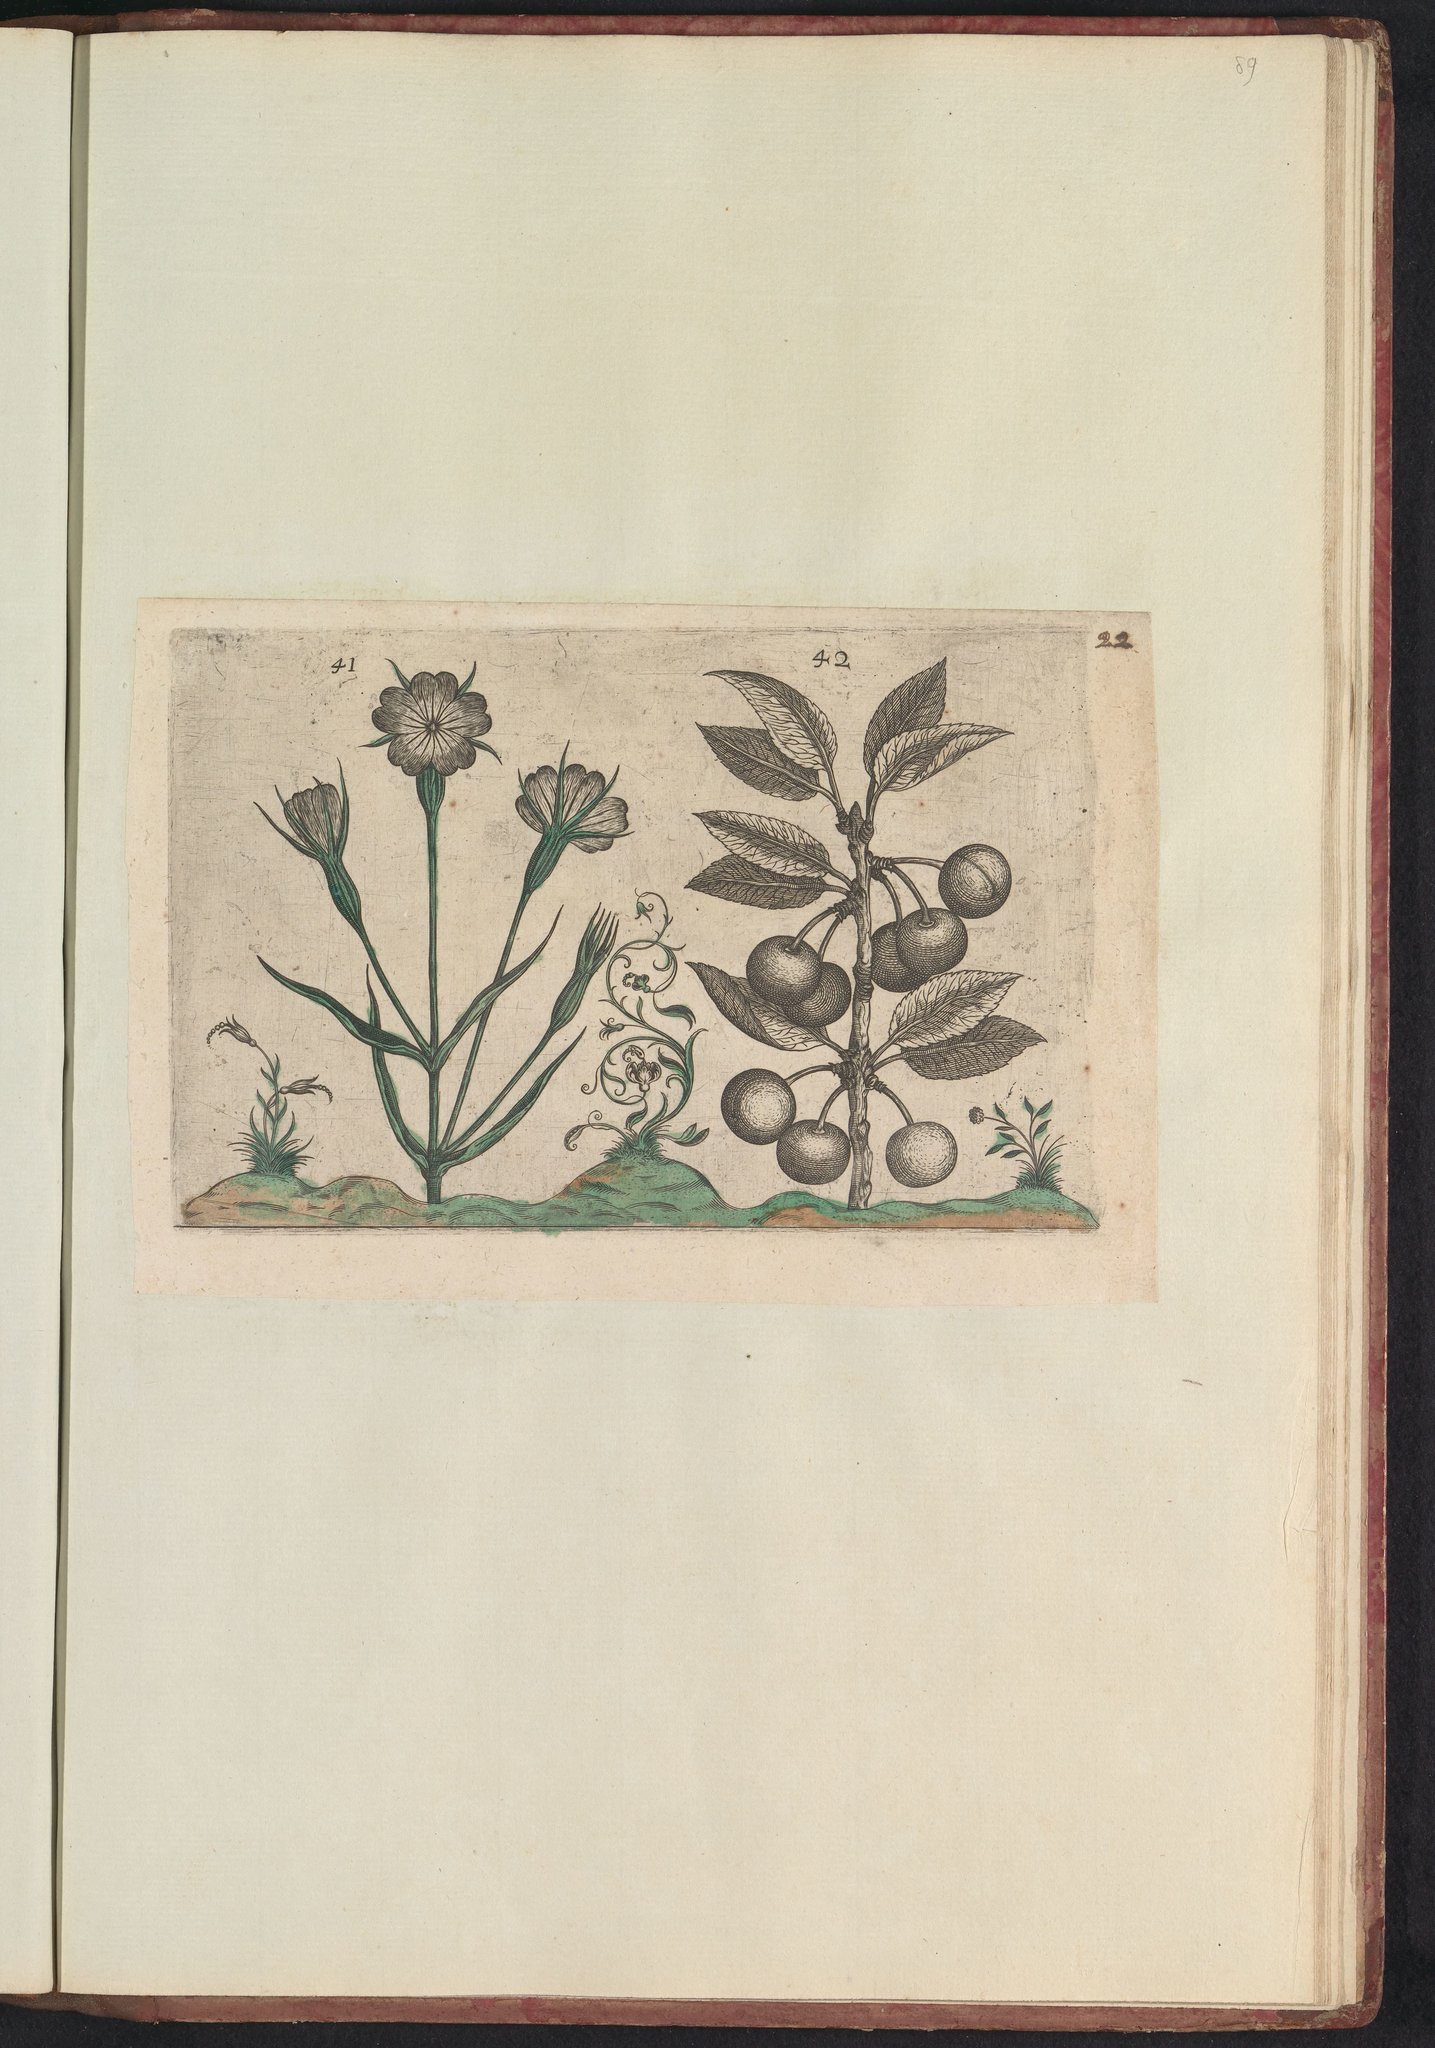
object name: print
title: Bolderik (Agrostemma githago) en zure kers (Prunus cerasus)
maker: Anonymous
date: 1604-1632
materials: ink, paper, watercolor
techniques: engraving, hand coloring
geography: cologne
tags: flowers: corncockle, fruits: sour cherry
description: Bolderik en zure kers. Met enkele ornamentele planten en ranken. Figs. 41 en 42 op een blad met de hand genummerd 22. In: Anselmi Boëtii de Boot I.C. Brugensis & Rodolphi II. Imp. Roman. medici a cubiculis Florum, Herbarum, ac fructuum selectiorum icones, & vires pleraeque hactenus ignotæ. Onderdeel van het album met bladen en platen uit De Boodts herbarium van 1640. Het twaalfde van twaalf albums met aquarellen van dieren, vogels en planten bekend rond 1600, gemaakt in opdracht van keizer Rudolf II.